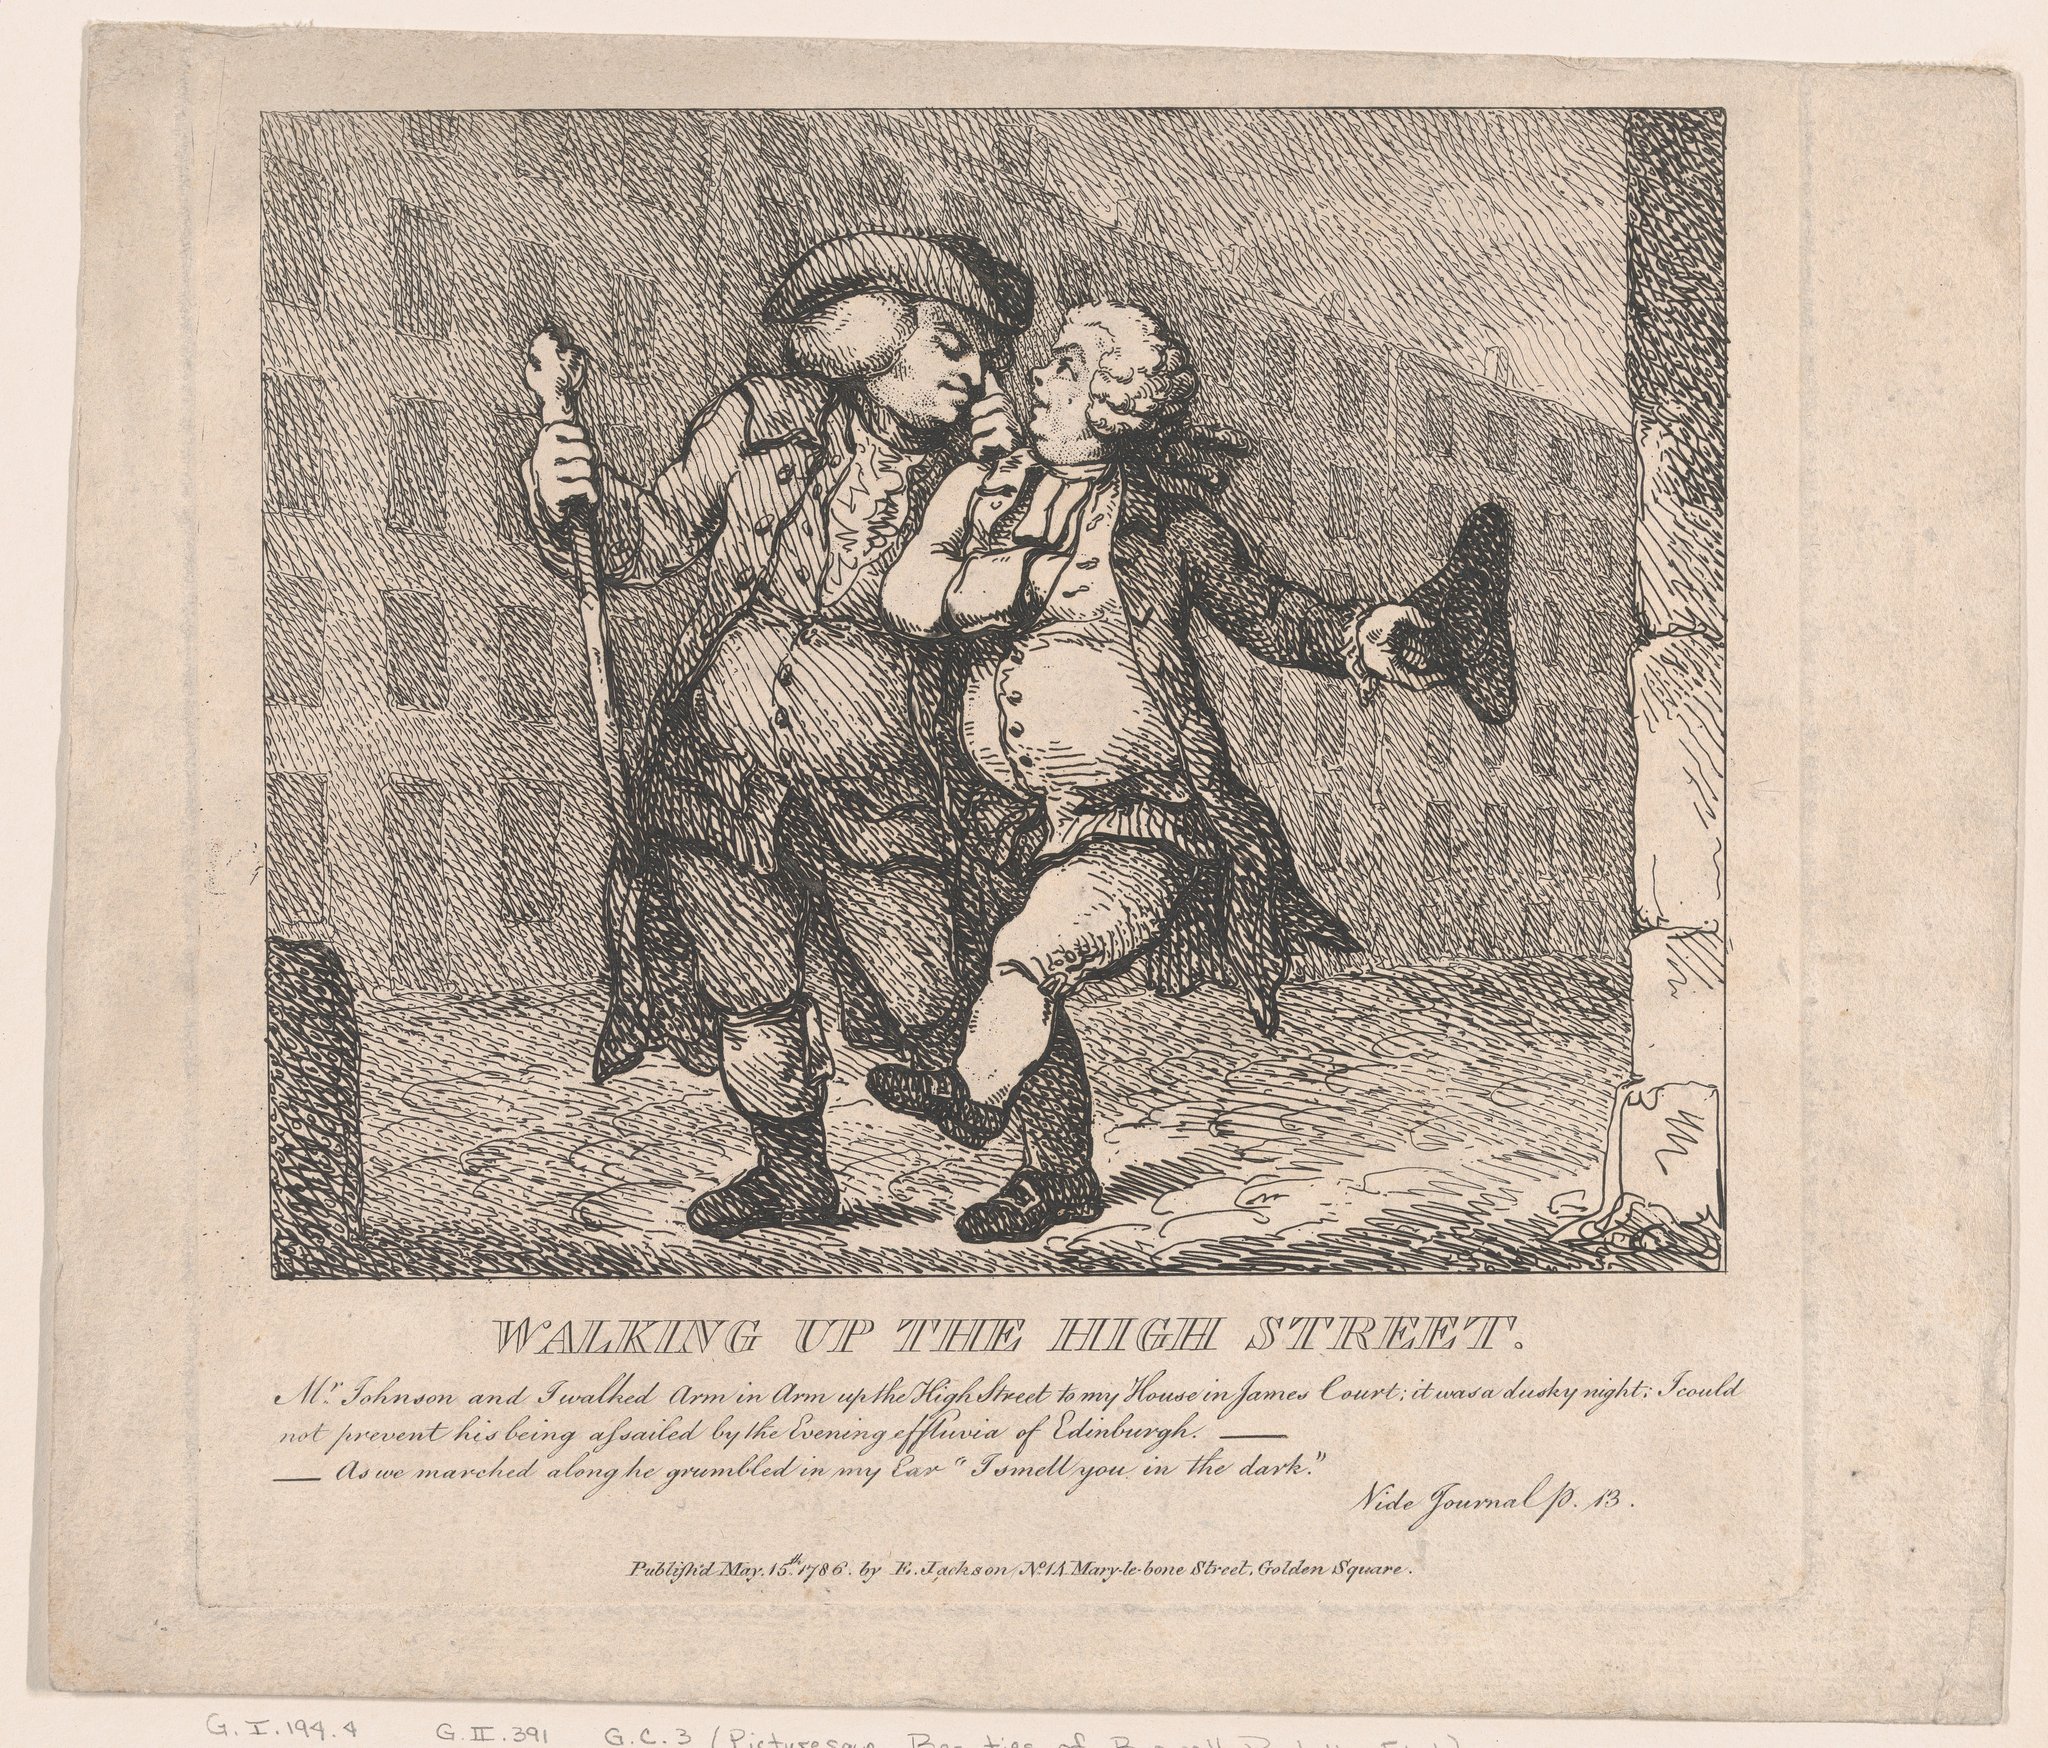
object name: print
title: Walking Up the High Street, Edinburgh (Picturesque Beauties of Boswell, Part the First)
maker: thomas rowlandson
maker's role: artist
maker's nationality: british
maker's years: 1757-1827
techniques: etching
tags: streets,men,walking